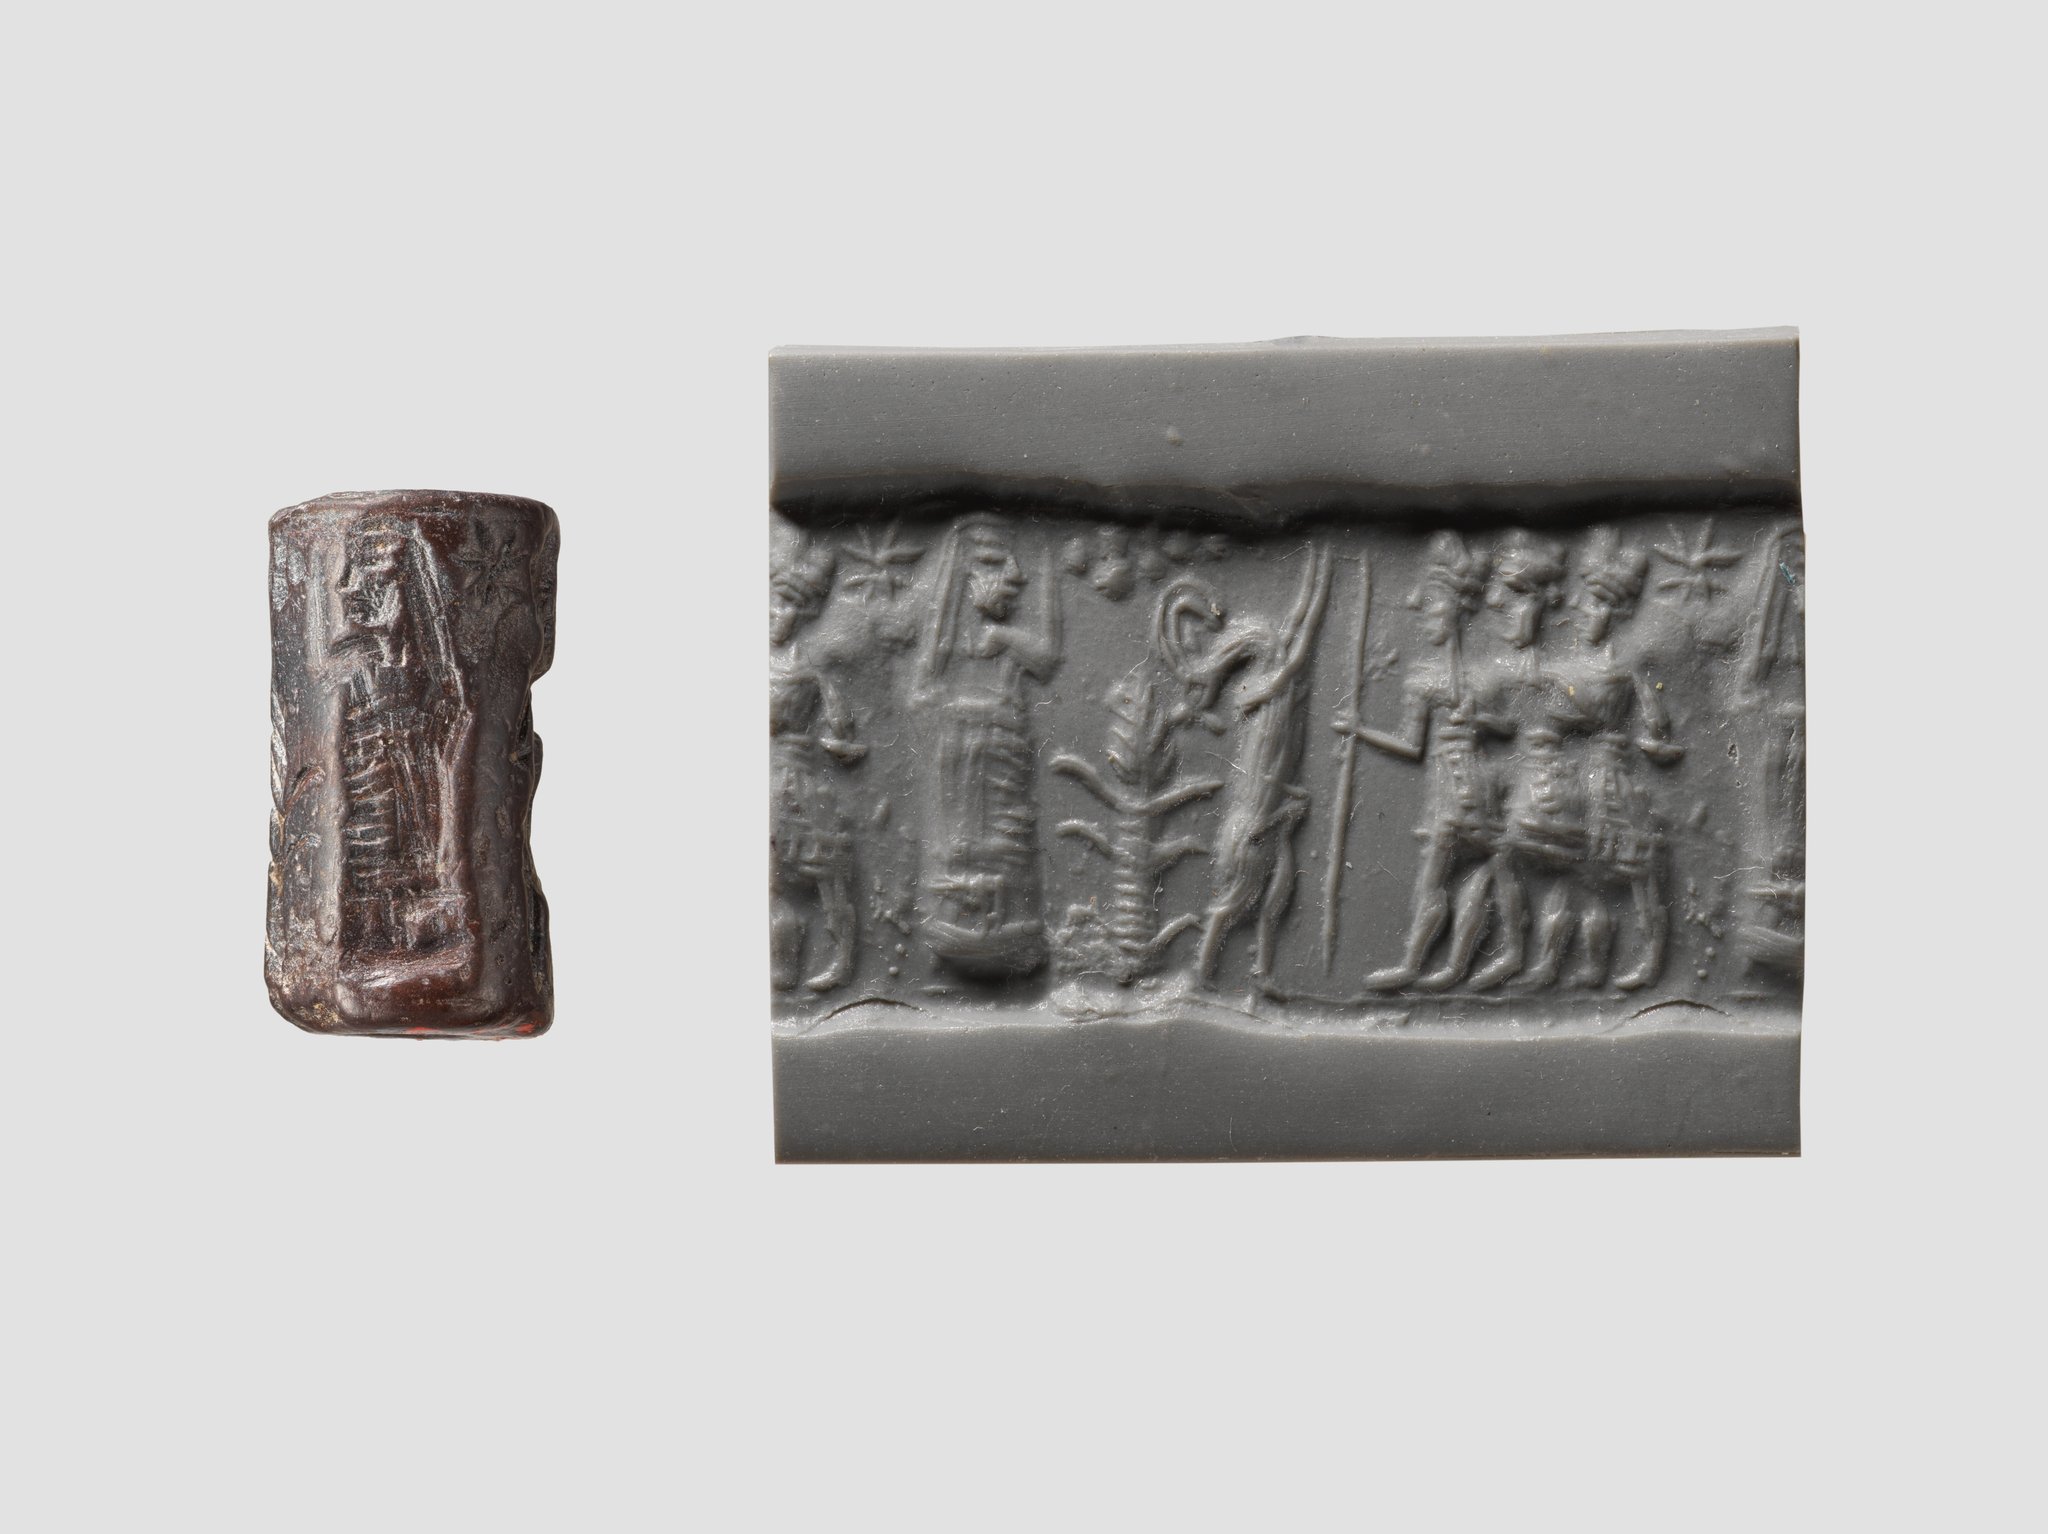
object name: cylinder seal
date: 1001-2000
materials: mineral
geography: syria